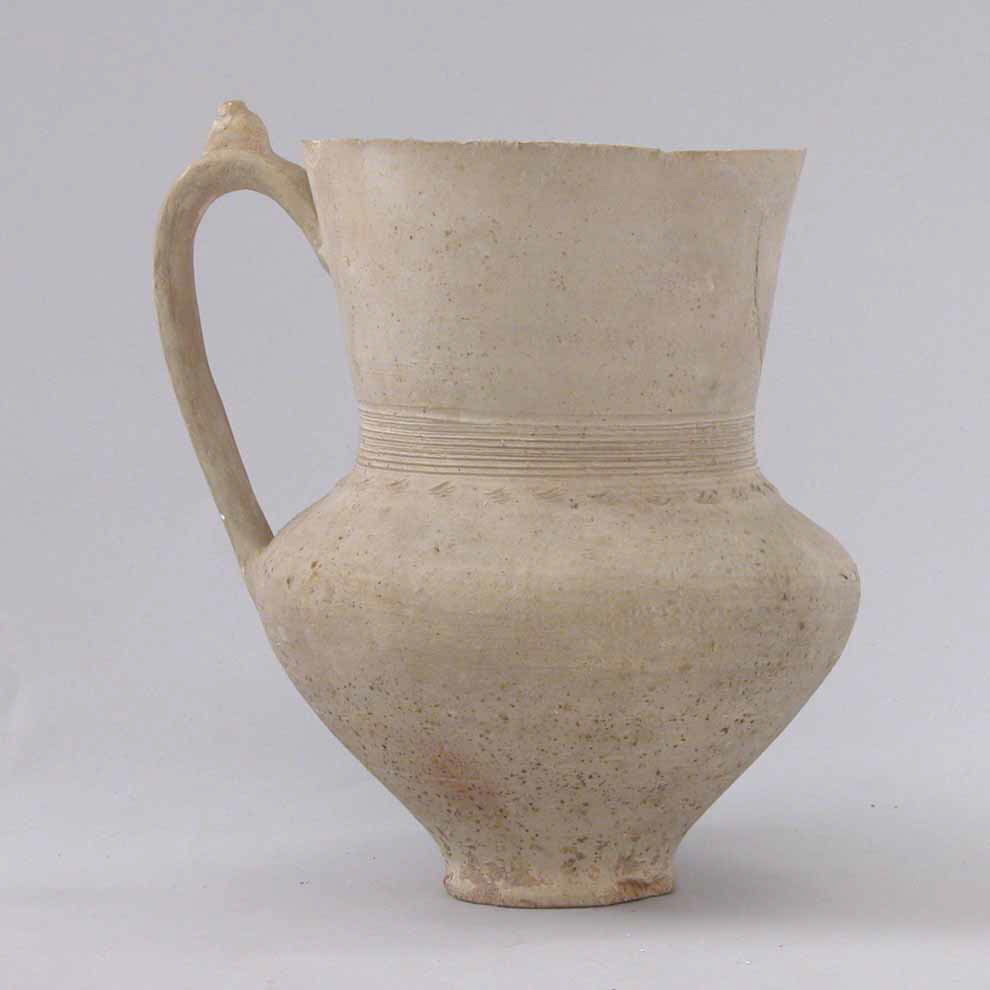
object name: jar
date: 767-900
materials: earthenware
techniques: incising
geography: iran